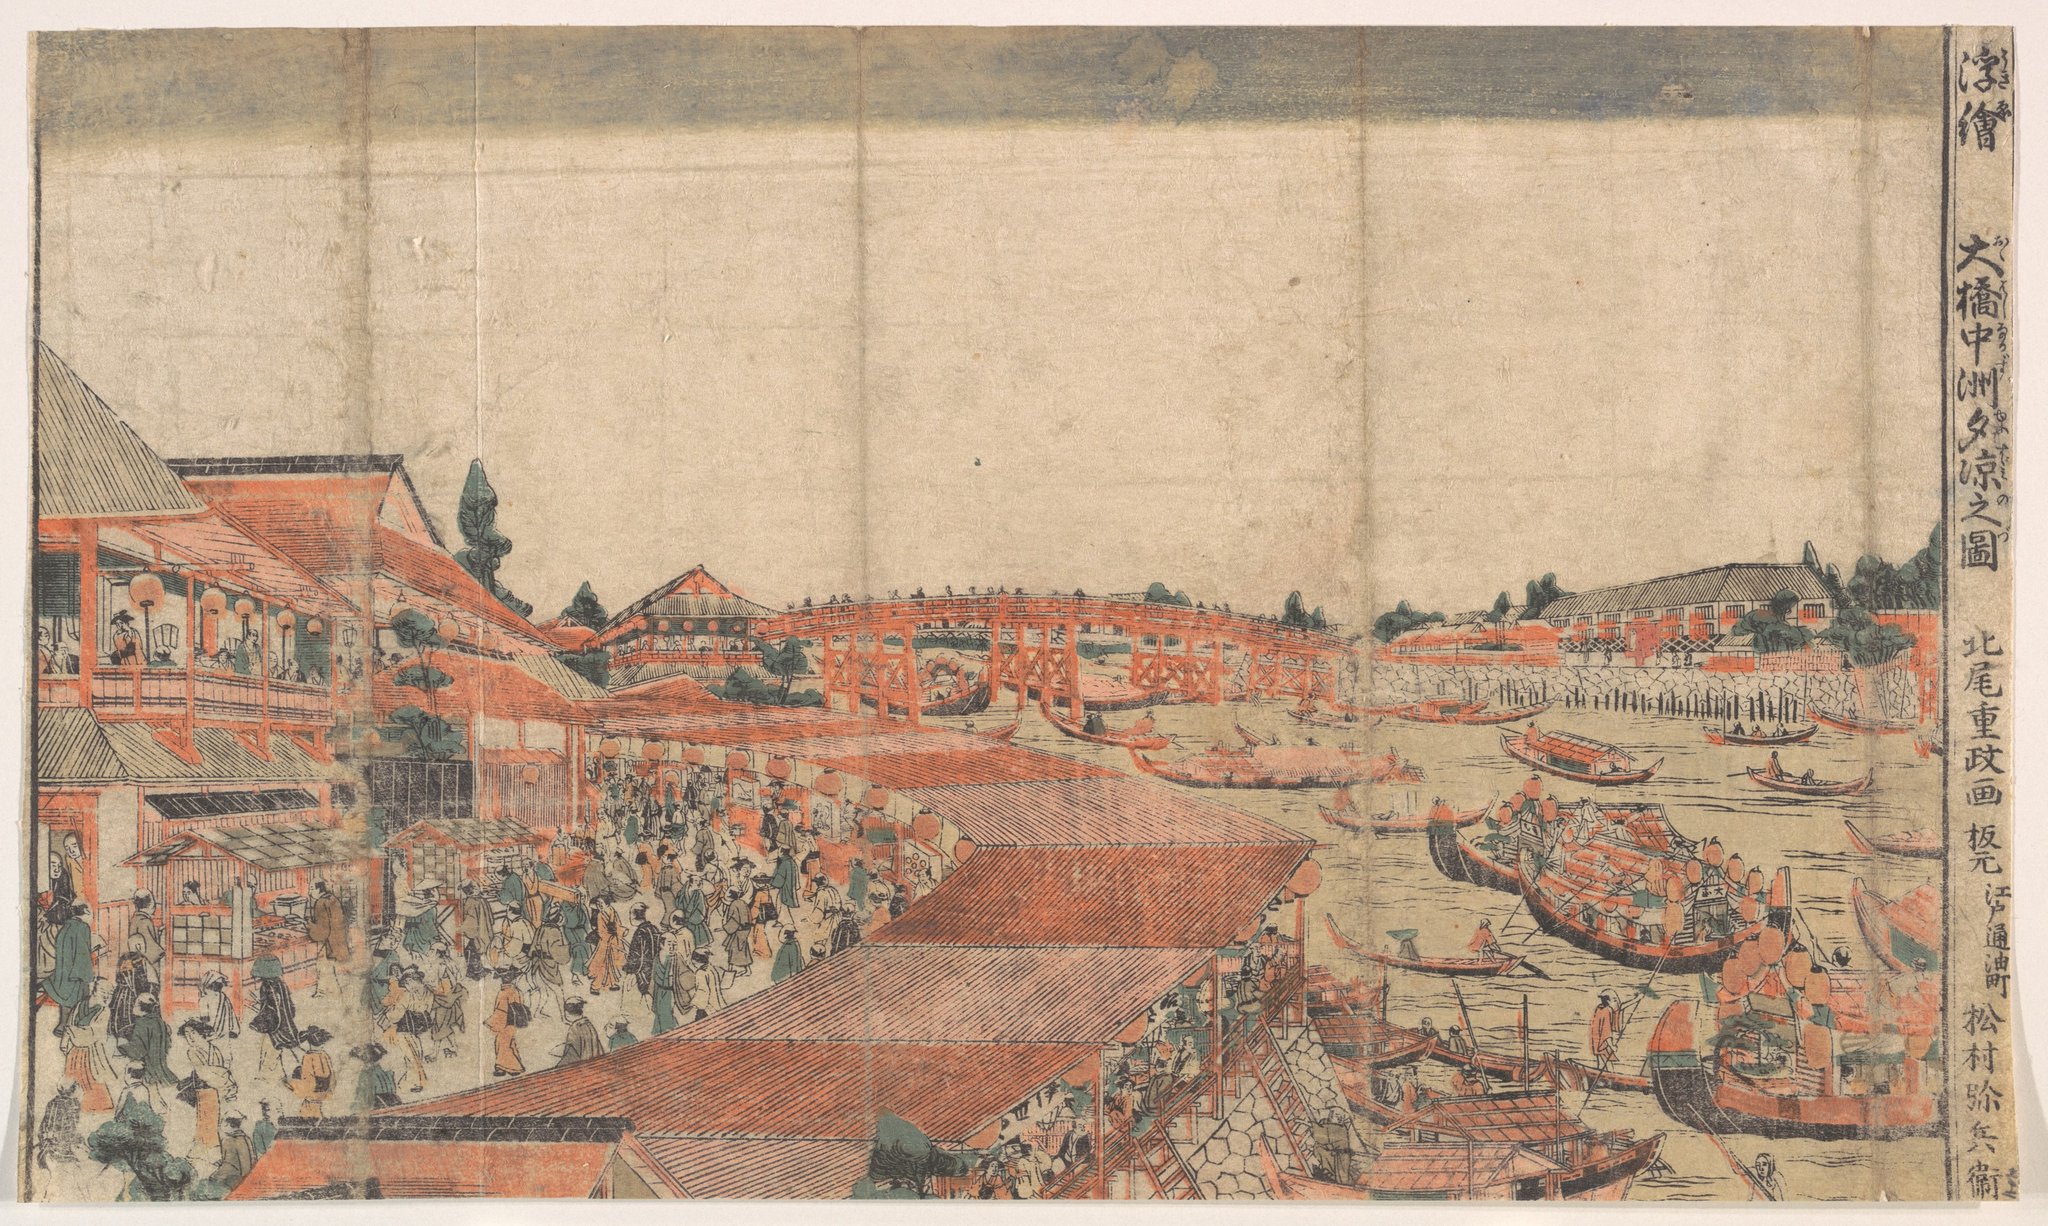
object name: print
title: Landscape; Showing Water Festival with Lanterns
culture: japanese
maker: kitao shigemasa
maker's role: artist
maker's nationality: japanese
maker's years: 1739-1820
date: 1739-1820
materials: ink, paper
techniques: woodblock print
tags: human figures,bridges,crowd,boats